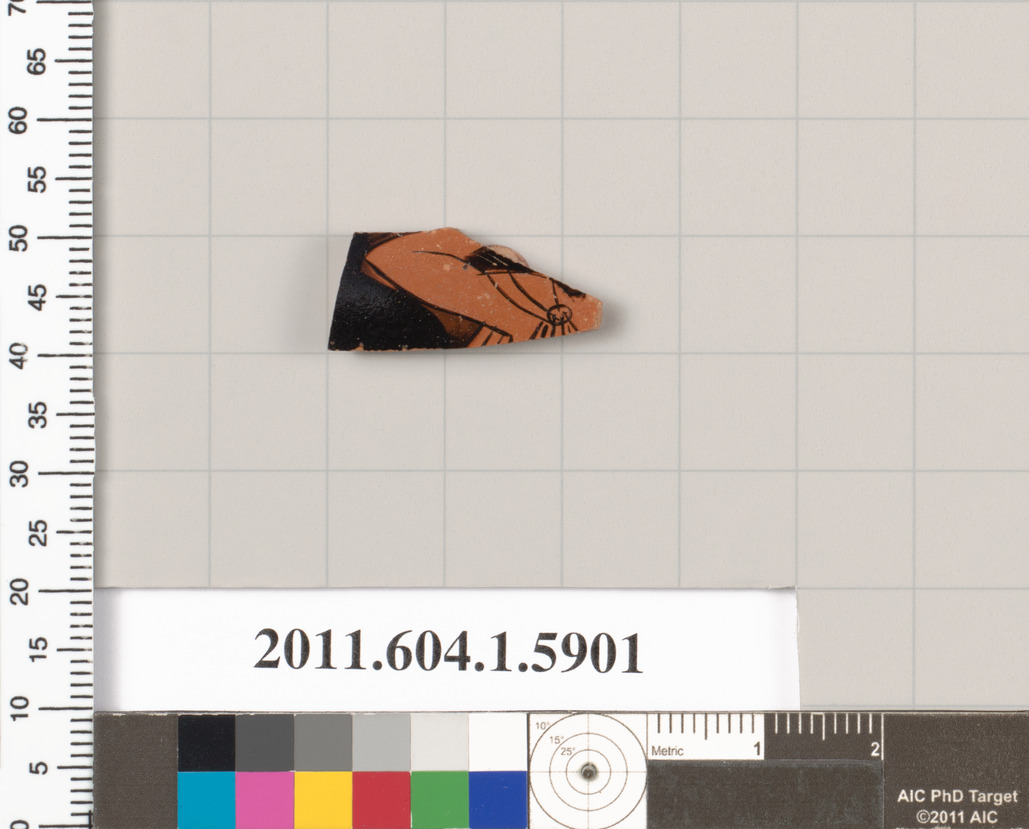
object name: kylix fragment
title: Terracotta fragment of a kylix (drinking cup)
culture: greek, attic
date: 520-510 BCE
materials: terracotta